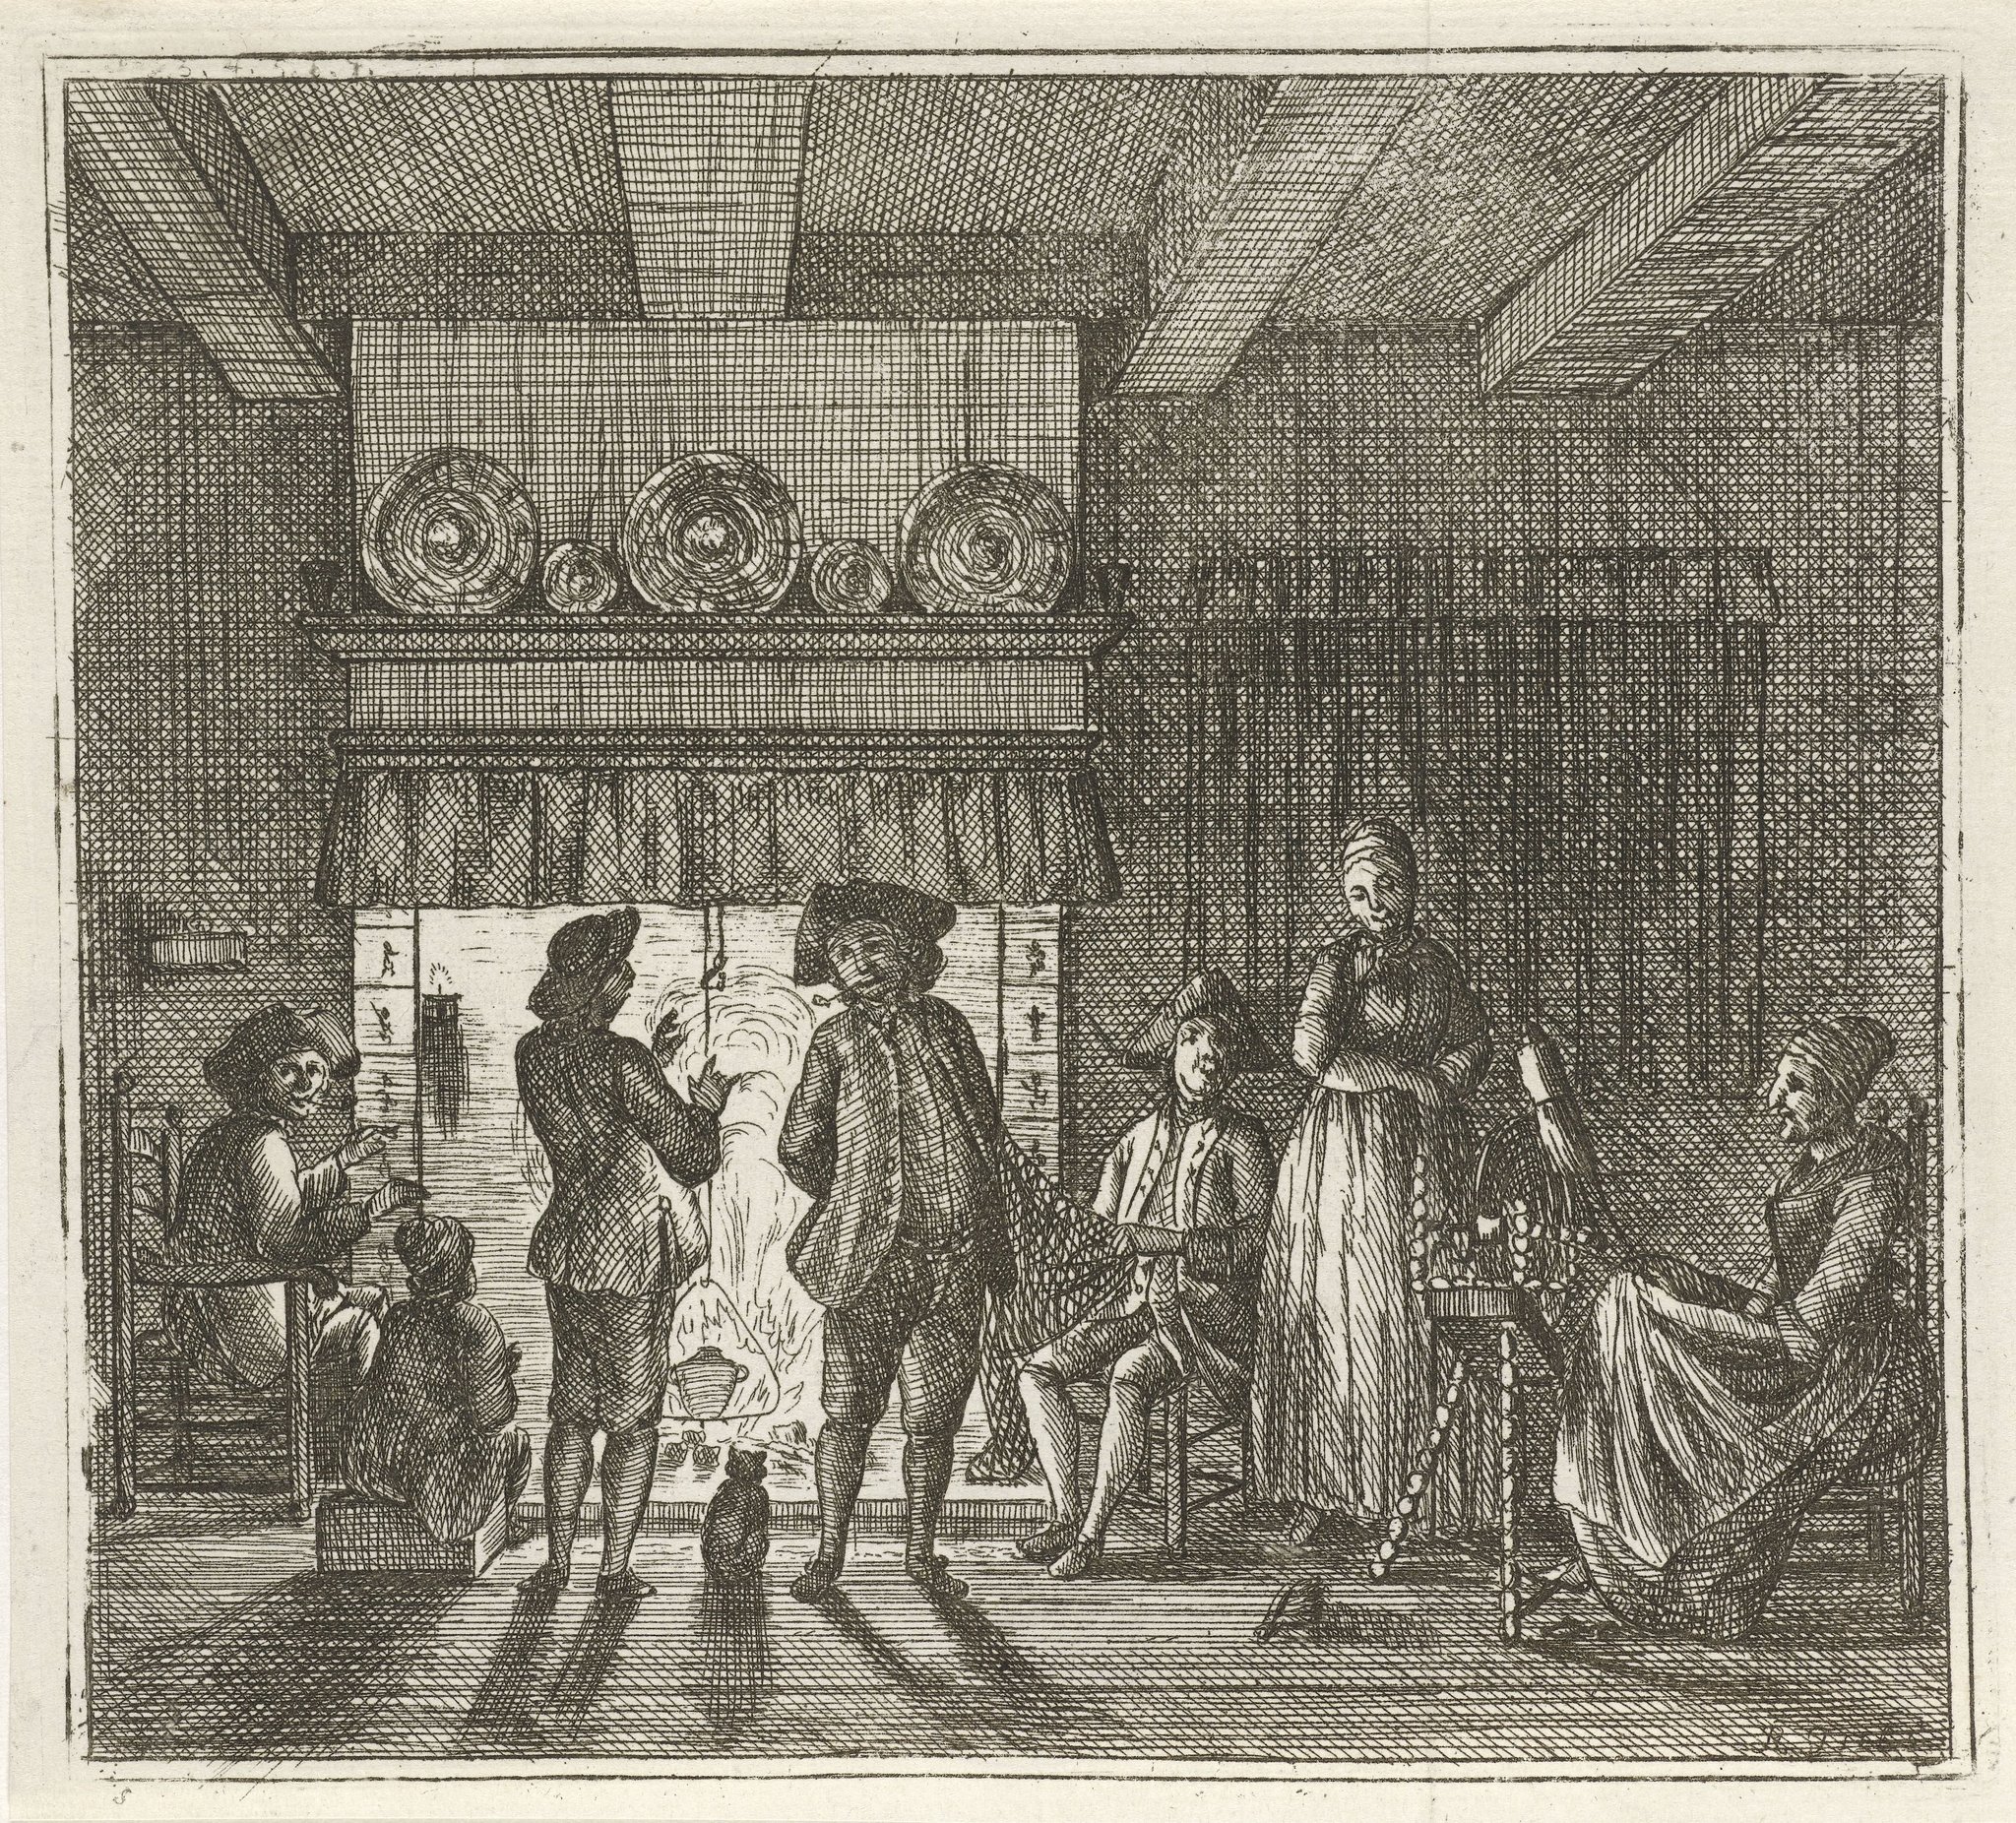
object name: print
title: Wintertaferelen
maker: rienk jelgerhuis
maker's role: draughtsman, print maker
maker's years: 1729-1806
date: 1765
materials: paper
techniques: engraving, etching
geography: leeuwarden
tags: warming oneself at a fire (or hearth, stove, fire-pan, brazier)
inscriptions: collector's mark: Lugt 2228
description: Interieur met figuren bij de open haard en een poes. Rechts is een vrouw aan het spinnen. Prent uit een serie van dertien met wintertaferelen.